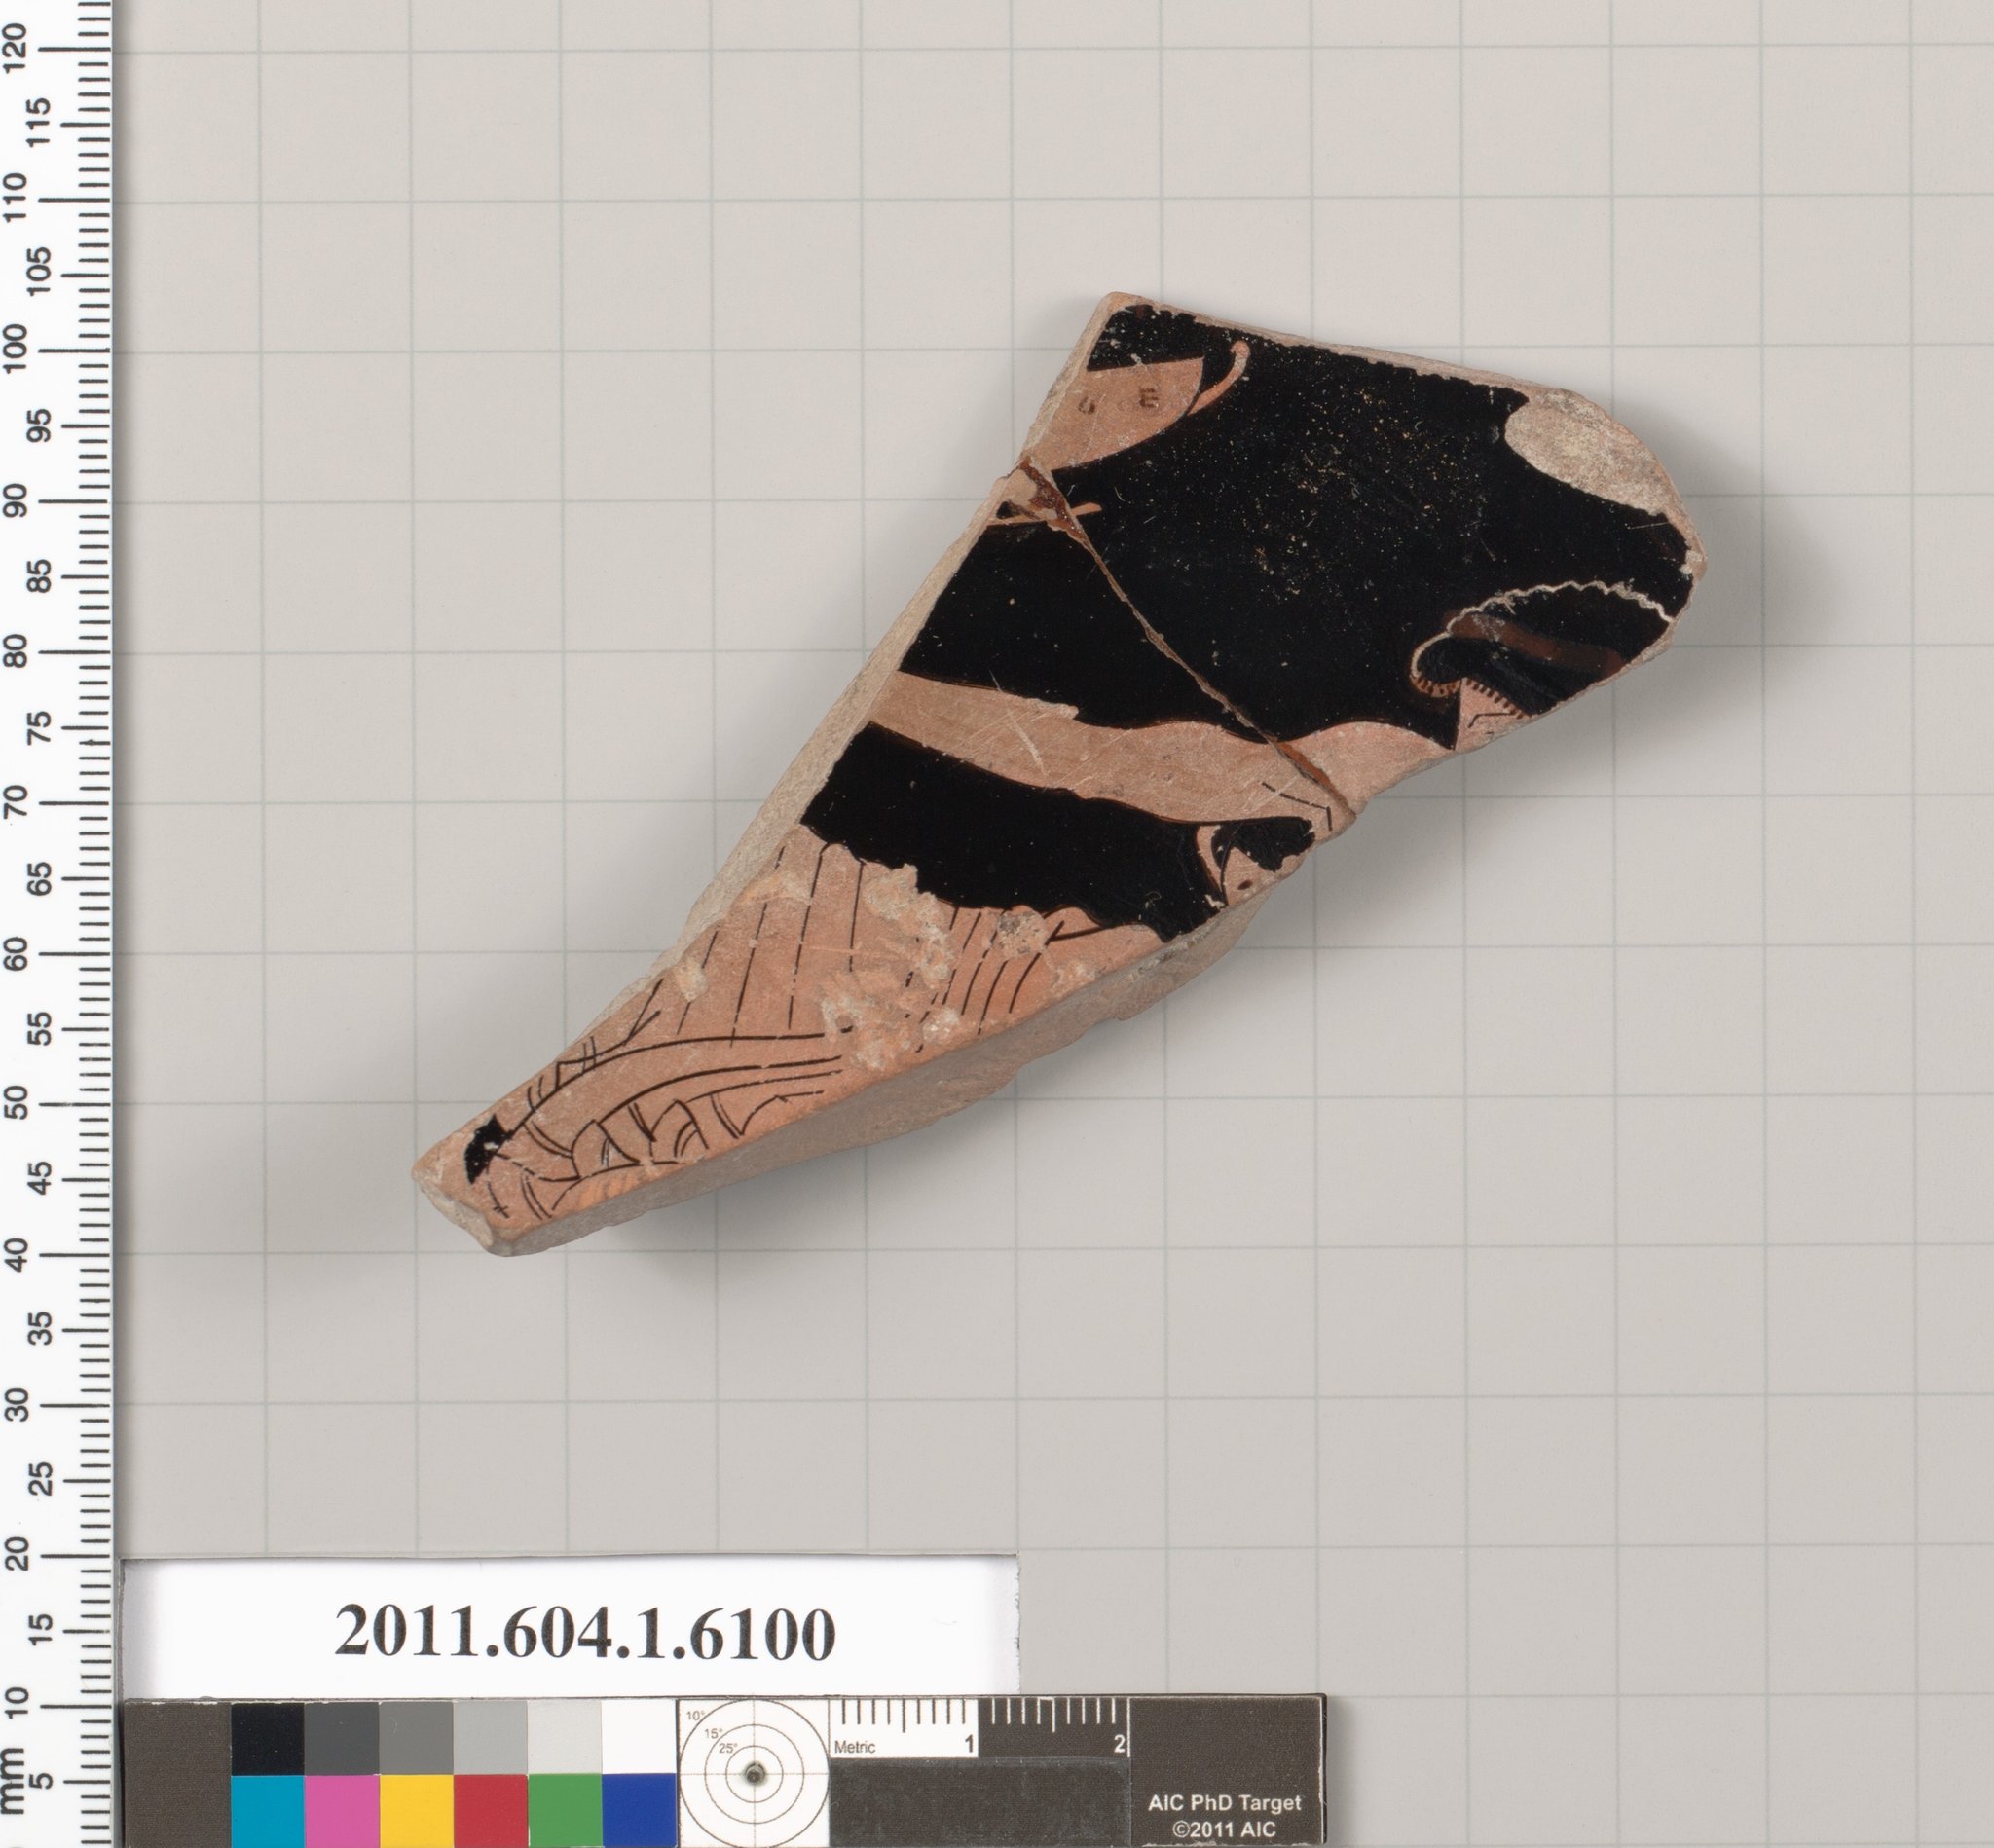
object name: kylix fragment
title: Terracotta fragment of a kylix (drinking cup)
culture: greek, attic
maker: apollodoros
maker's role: artist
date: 500-490 BCE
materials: terracotta